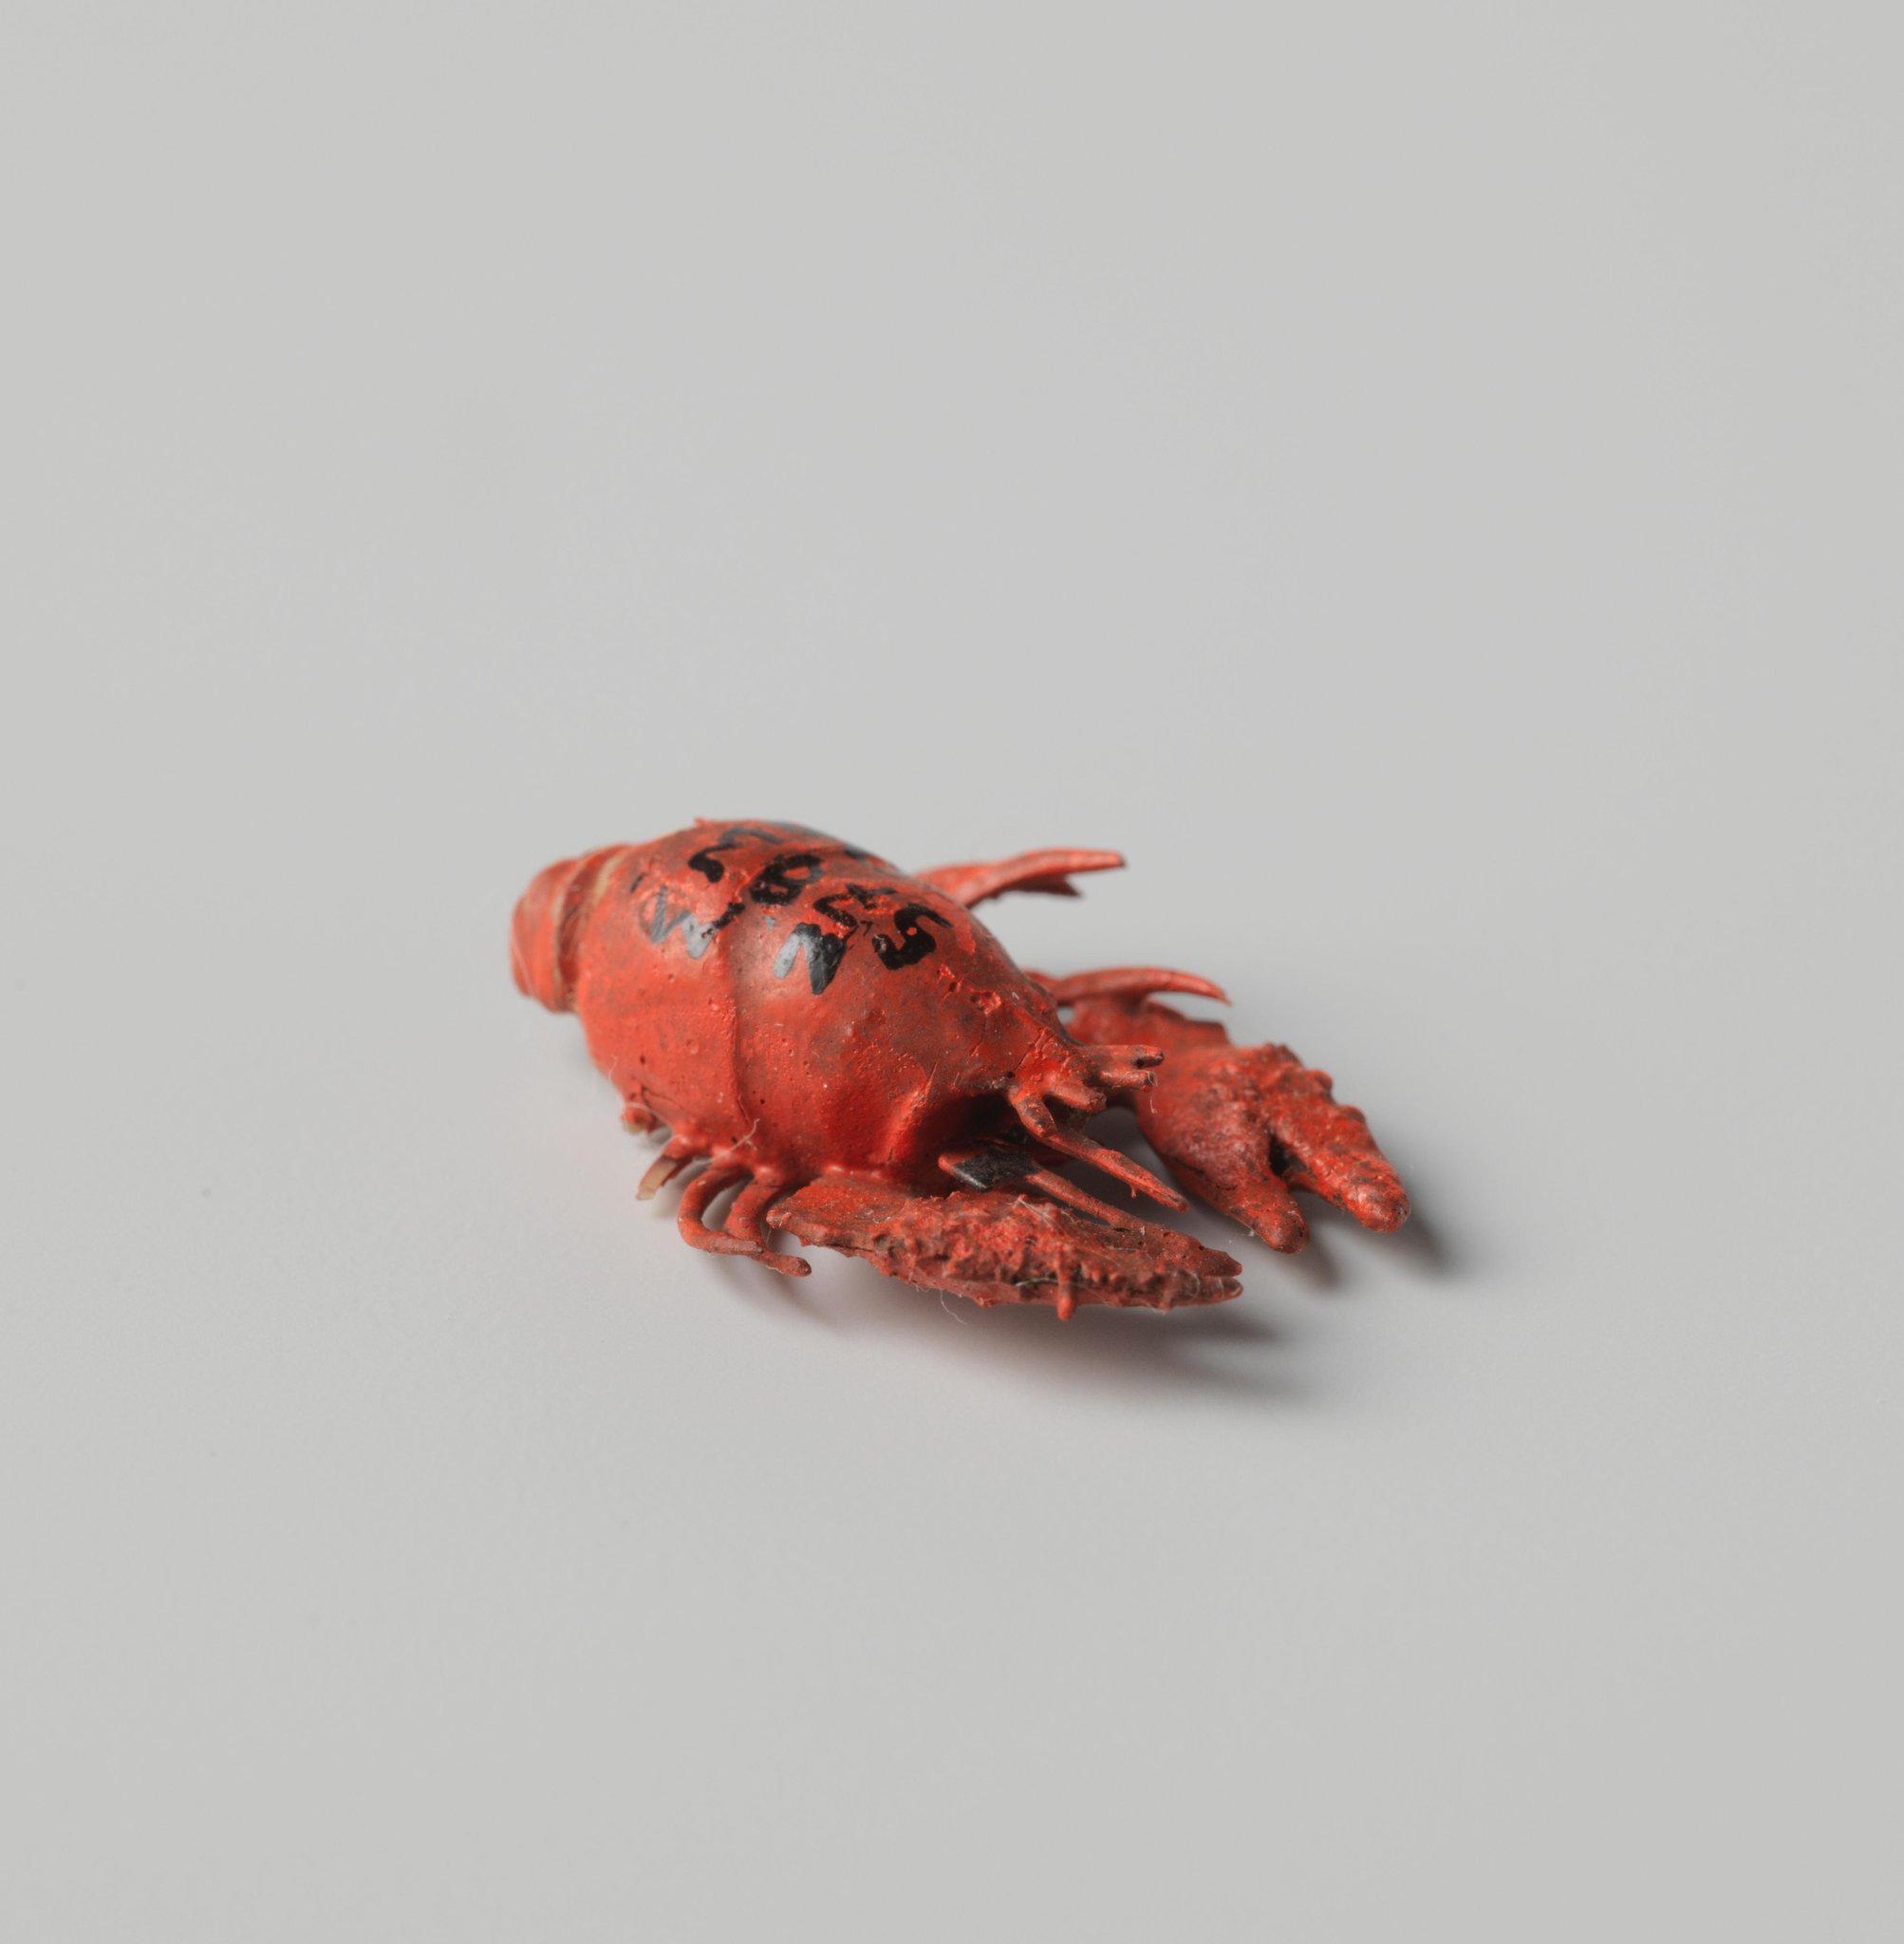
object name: miniature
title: Kreeft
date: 1700-1799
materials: papier mâché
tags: fish; still life of fishes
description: Kreeft, rood, gemaakt van onduidelijke substantie.